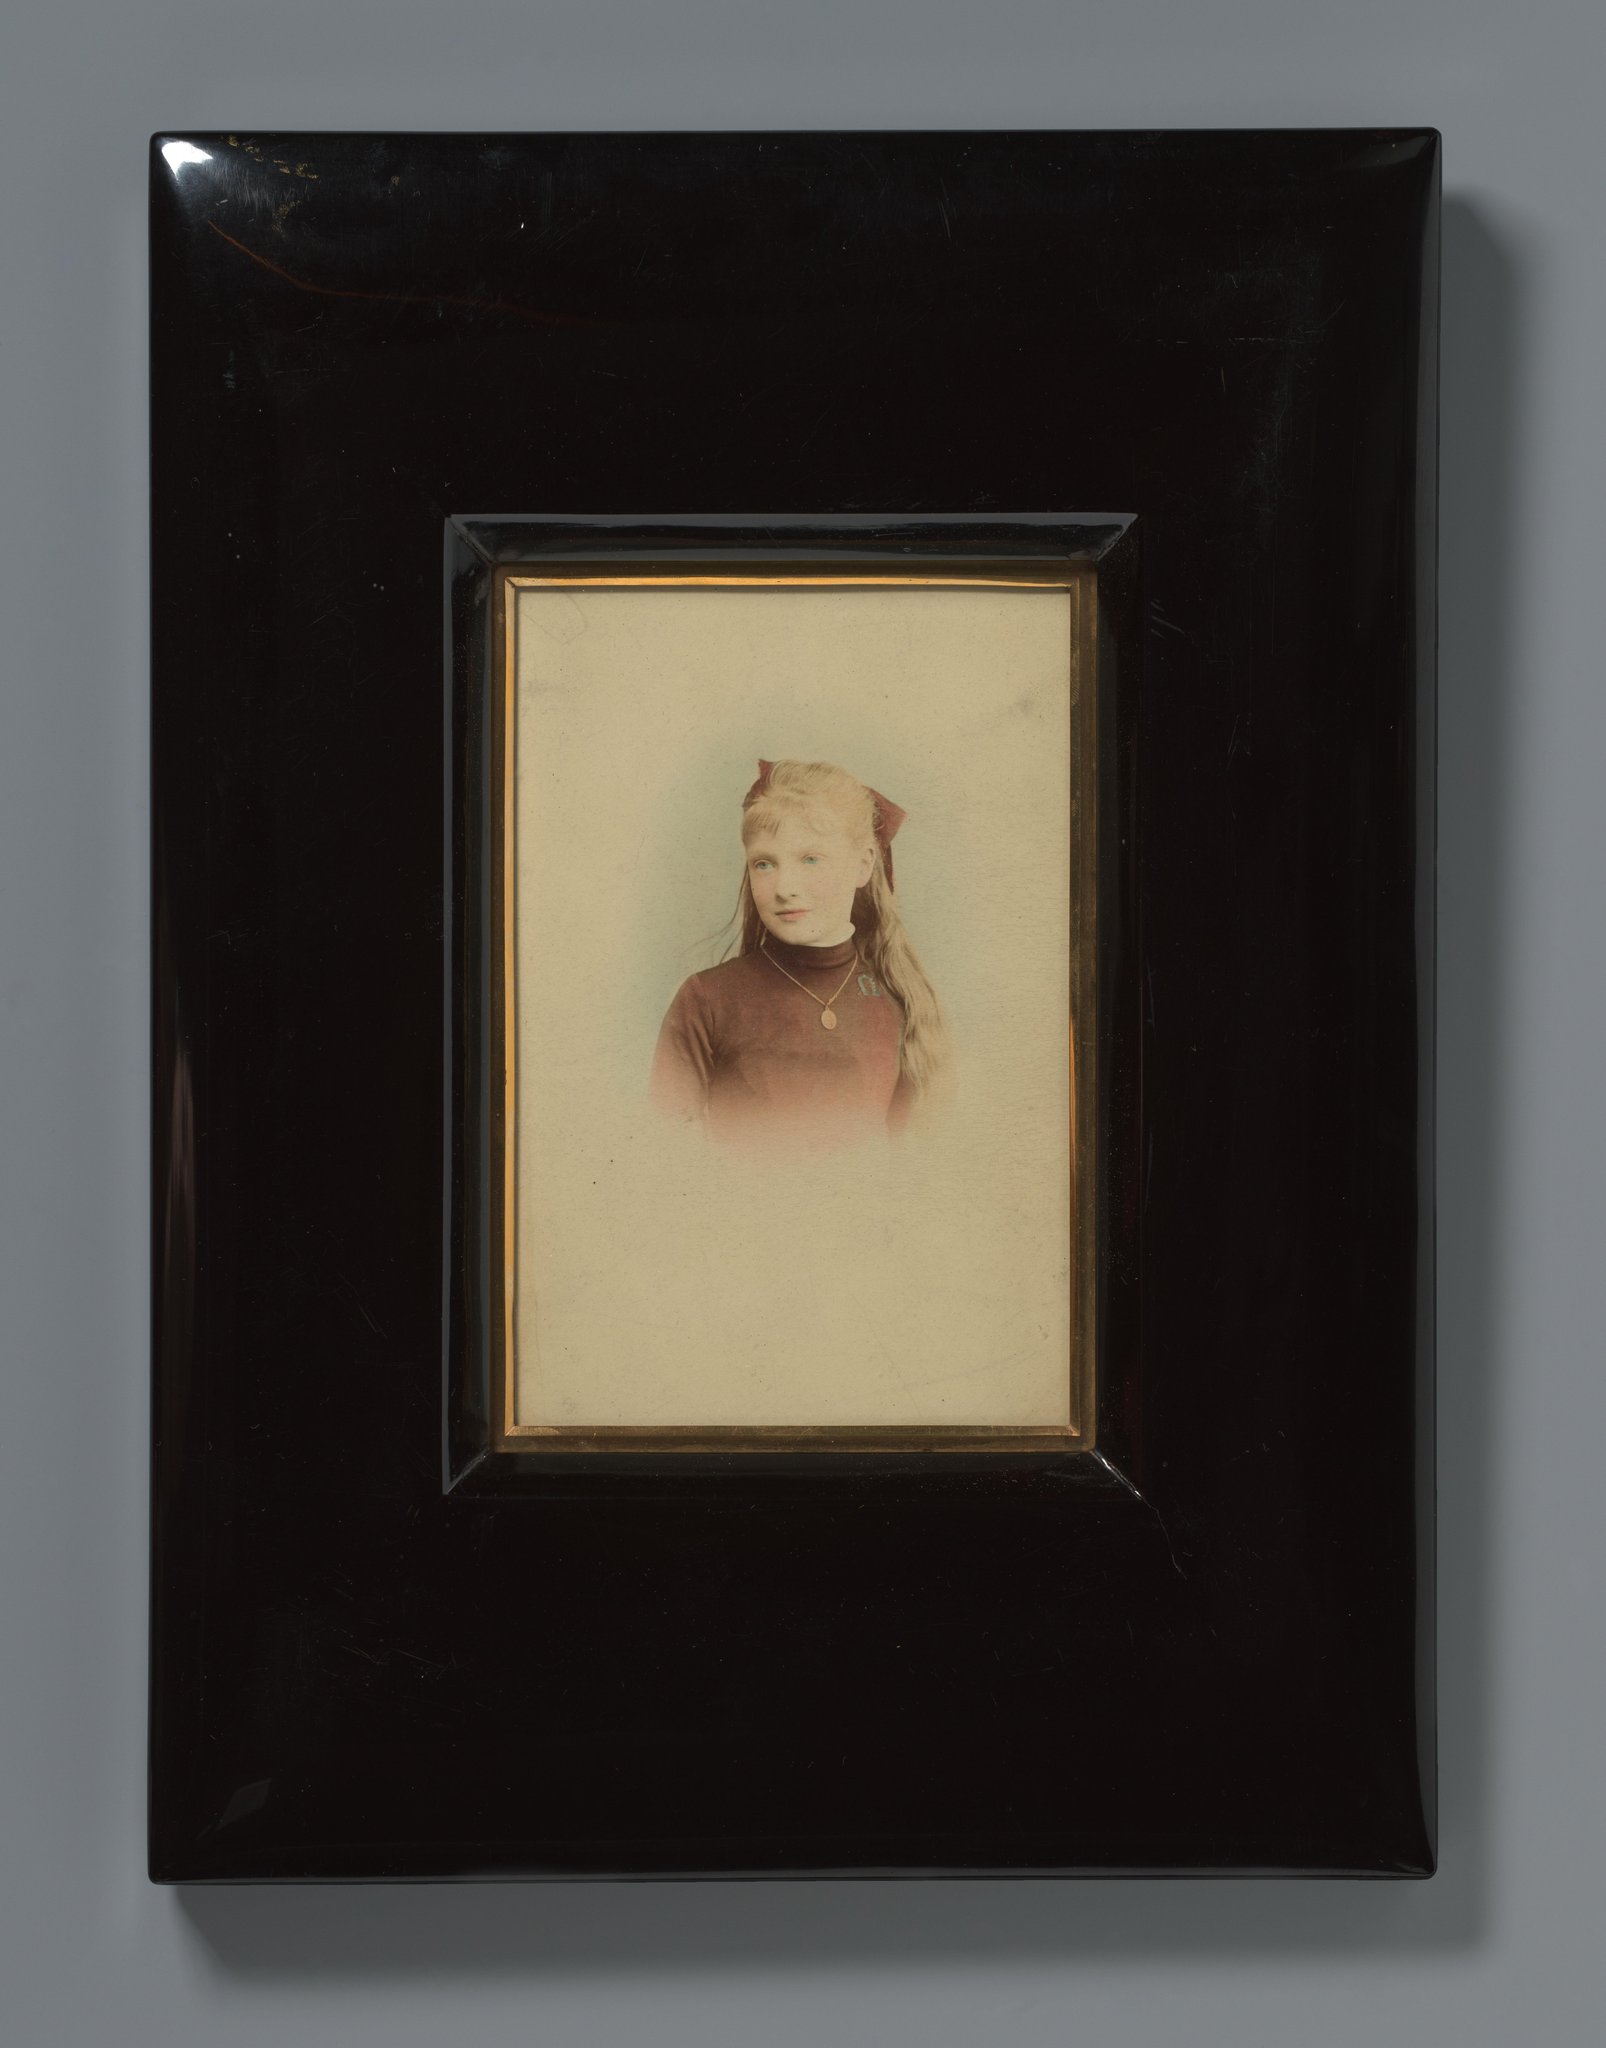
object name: photograph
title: Portret van een onbekend meisje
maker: Anonymous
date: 1890-1910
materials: glass, metal, paper, fiber, wood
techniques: albumen print, hand coloring, lacquer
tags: historical persons not known by name - bb - woman, girl (child between toddler and youth)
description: Portret van een onbekend meisje, in zwarte Japanse laklijst.